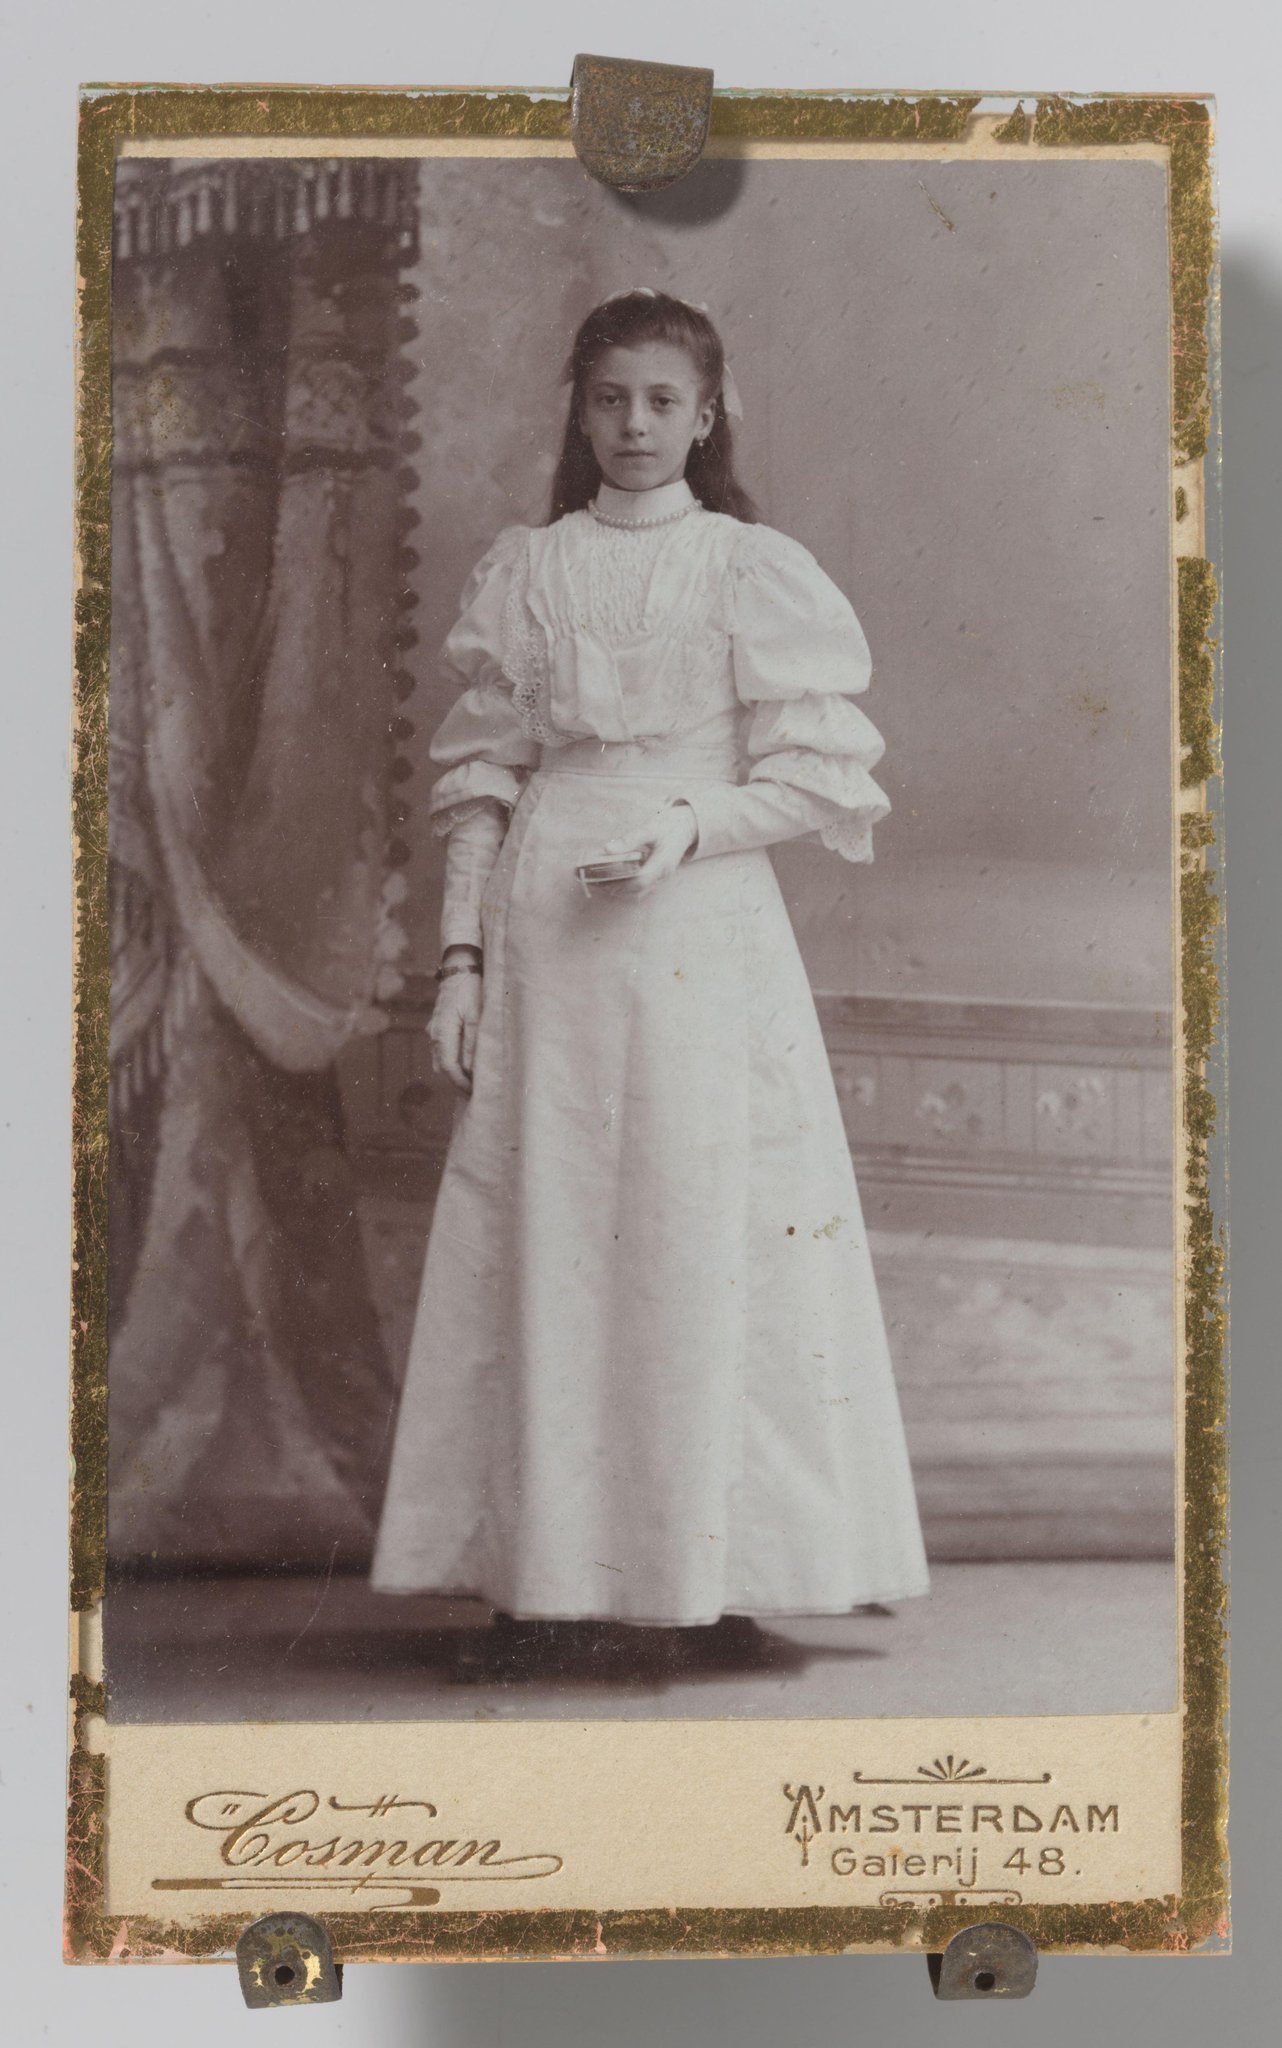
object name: photograph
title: Portret van een onbekend meisje in jurk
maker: max cosman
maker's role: fotograaf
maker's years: 1852-1894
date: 1881-1903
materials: paper, cardboard, glass, metal, wood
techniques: collodion silver print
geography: amsterdam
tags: girl (child between toddler and youth), anonymous historical person portrayed, amsterdam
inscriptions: inscription: ‘Cosman/ AMSTERDAM/ Galerij 48.’